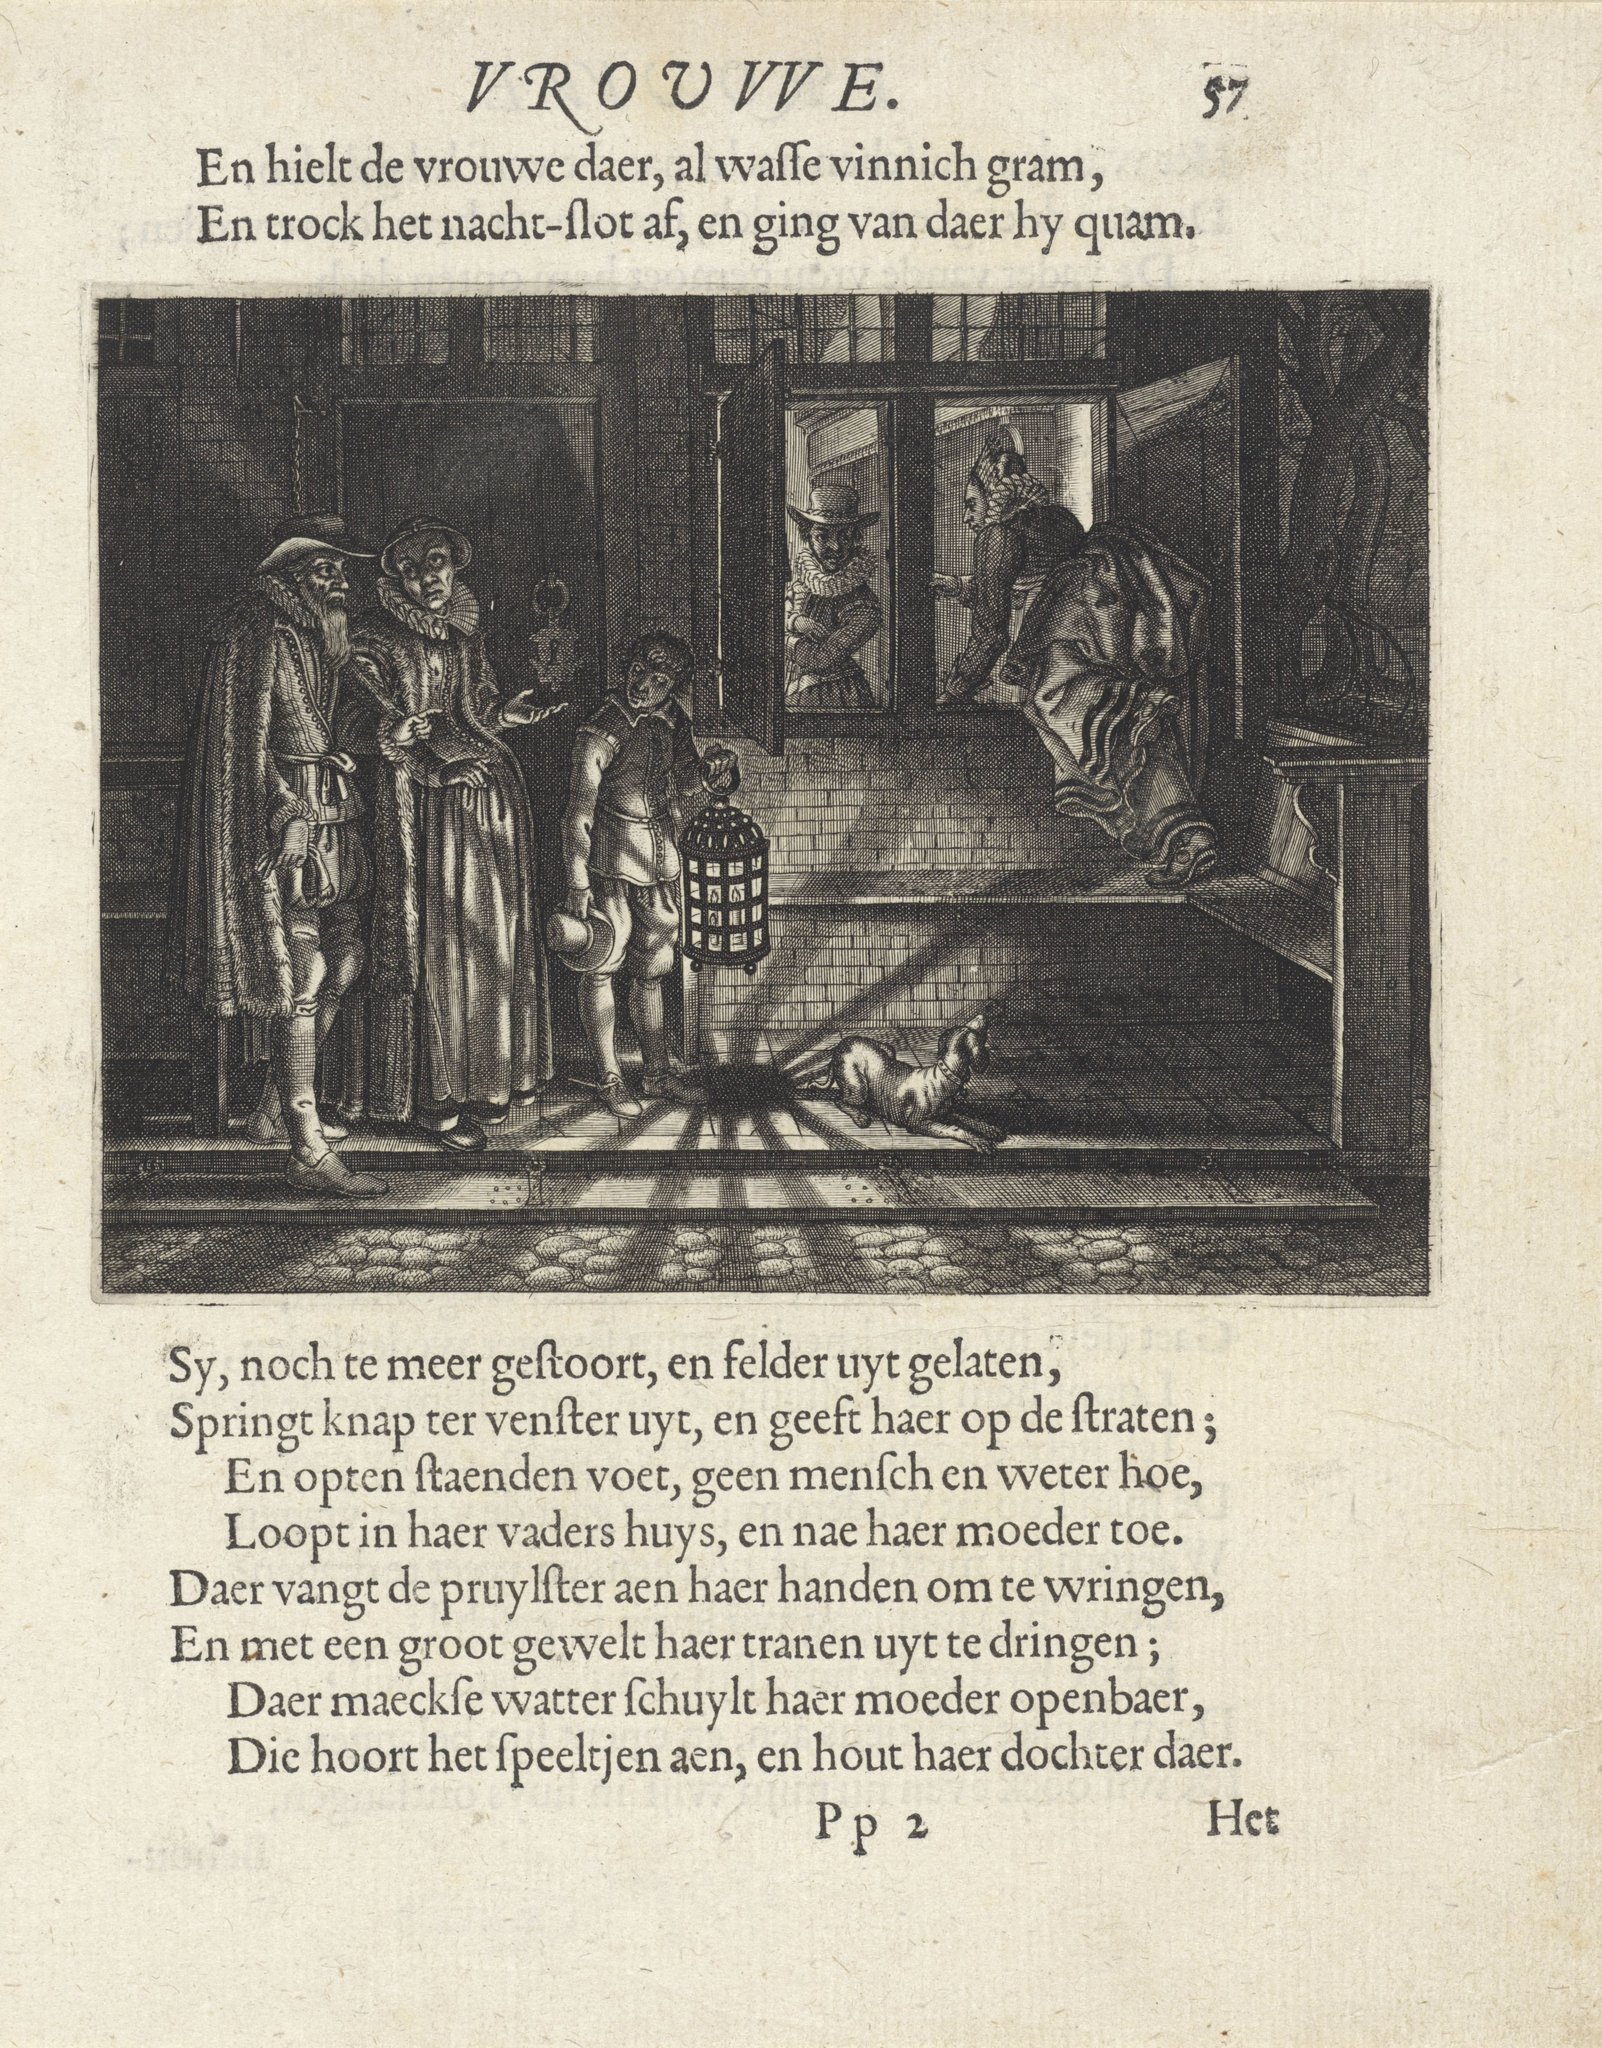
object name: book illustration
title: Vrouw klimt door een raam bij nacht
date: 1625-1635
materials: paper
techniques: engraving, letterpress printing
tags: climbing - aa - female human figure, lantern, open window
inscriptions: collector's mark: Lugt 2228, collector's mark: Lugt 2760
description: Boekillustratie in: Cats, Jacob. Hovwelyck. Dat is De gansche gelegentheyt des echten staets. Middelburg: Jan Pietersz van de Venne (wed.),1625-1626 en 's-Gravenhage: Adriaen van de Venne, 1625-1635.